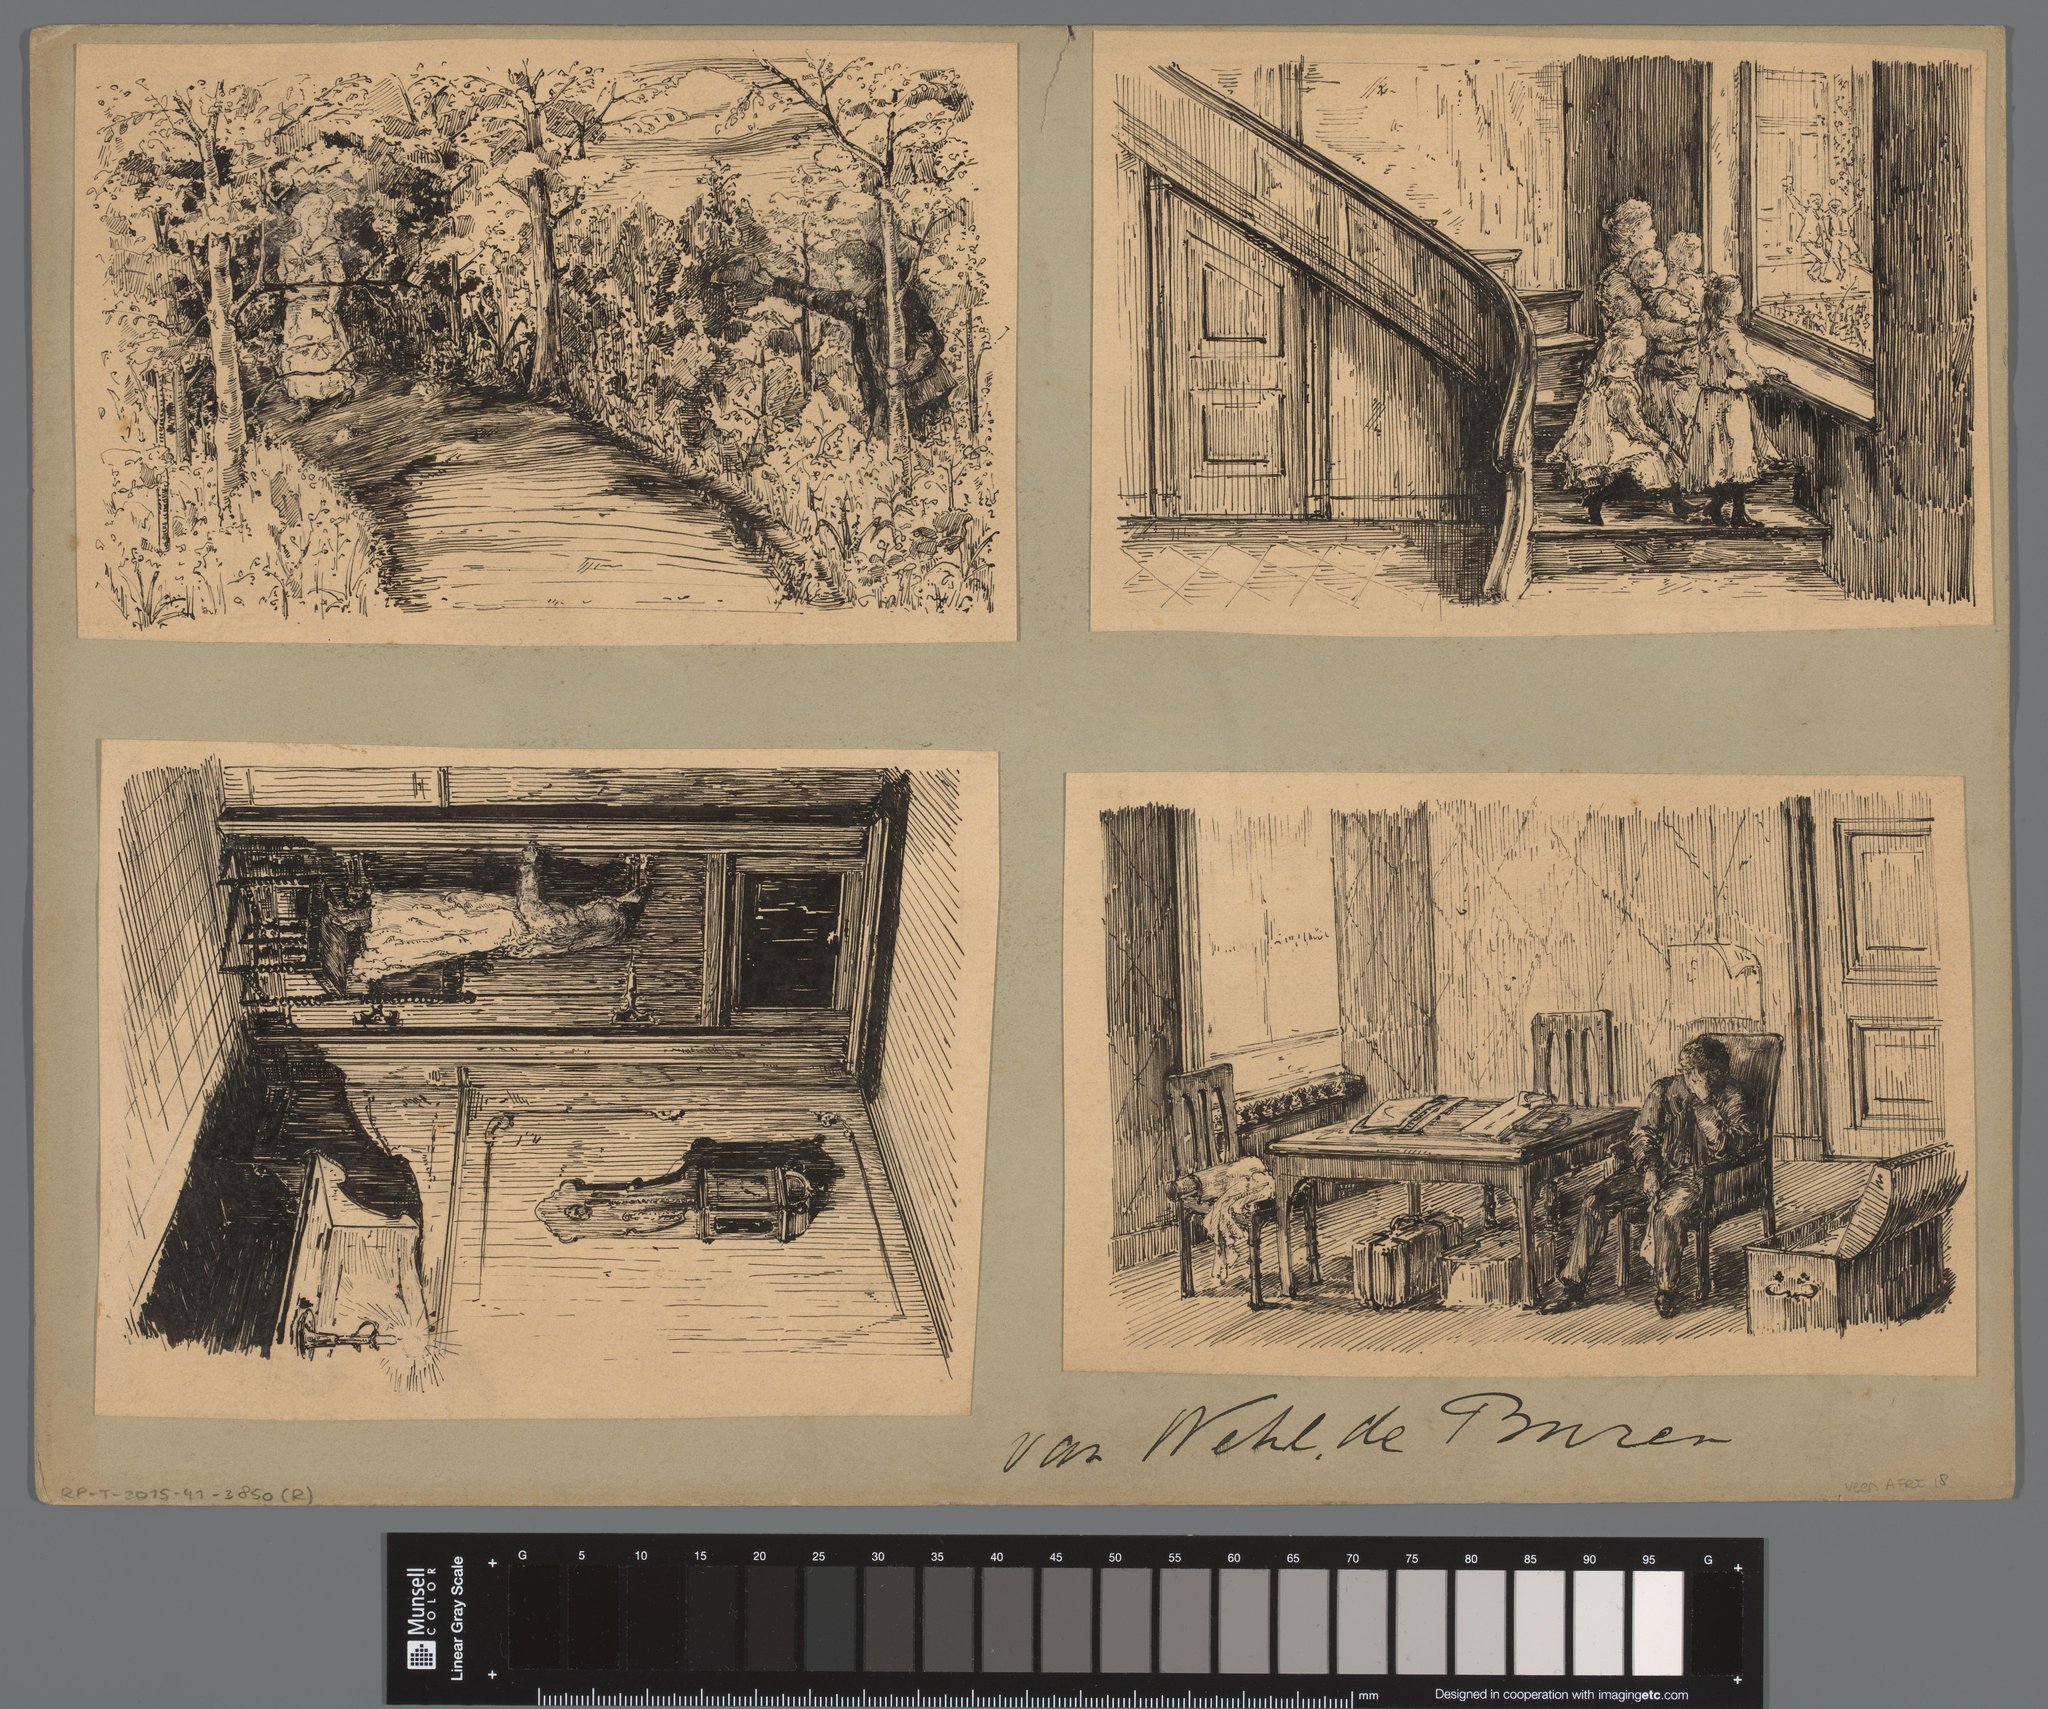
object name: boekillustratie ontwerp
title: Vier illustraties bij: Nannie van Wehl, De buren, 1907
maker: c. rovers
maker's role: illustrator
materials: cardboard, ink, paper, pencil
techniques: pen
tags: shrubs, door, weeping, staircase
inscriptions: annotation: ‘griseldis’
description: Ontwerp voor: Wehl, Nannie van. De buren. Amsterdam: Veen, 1907.